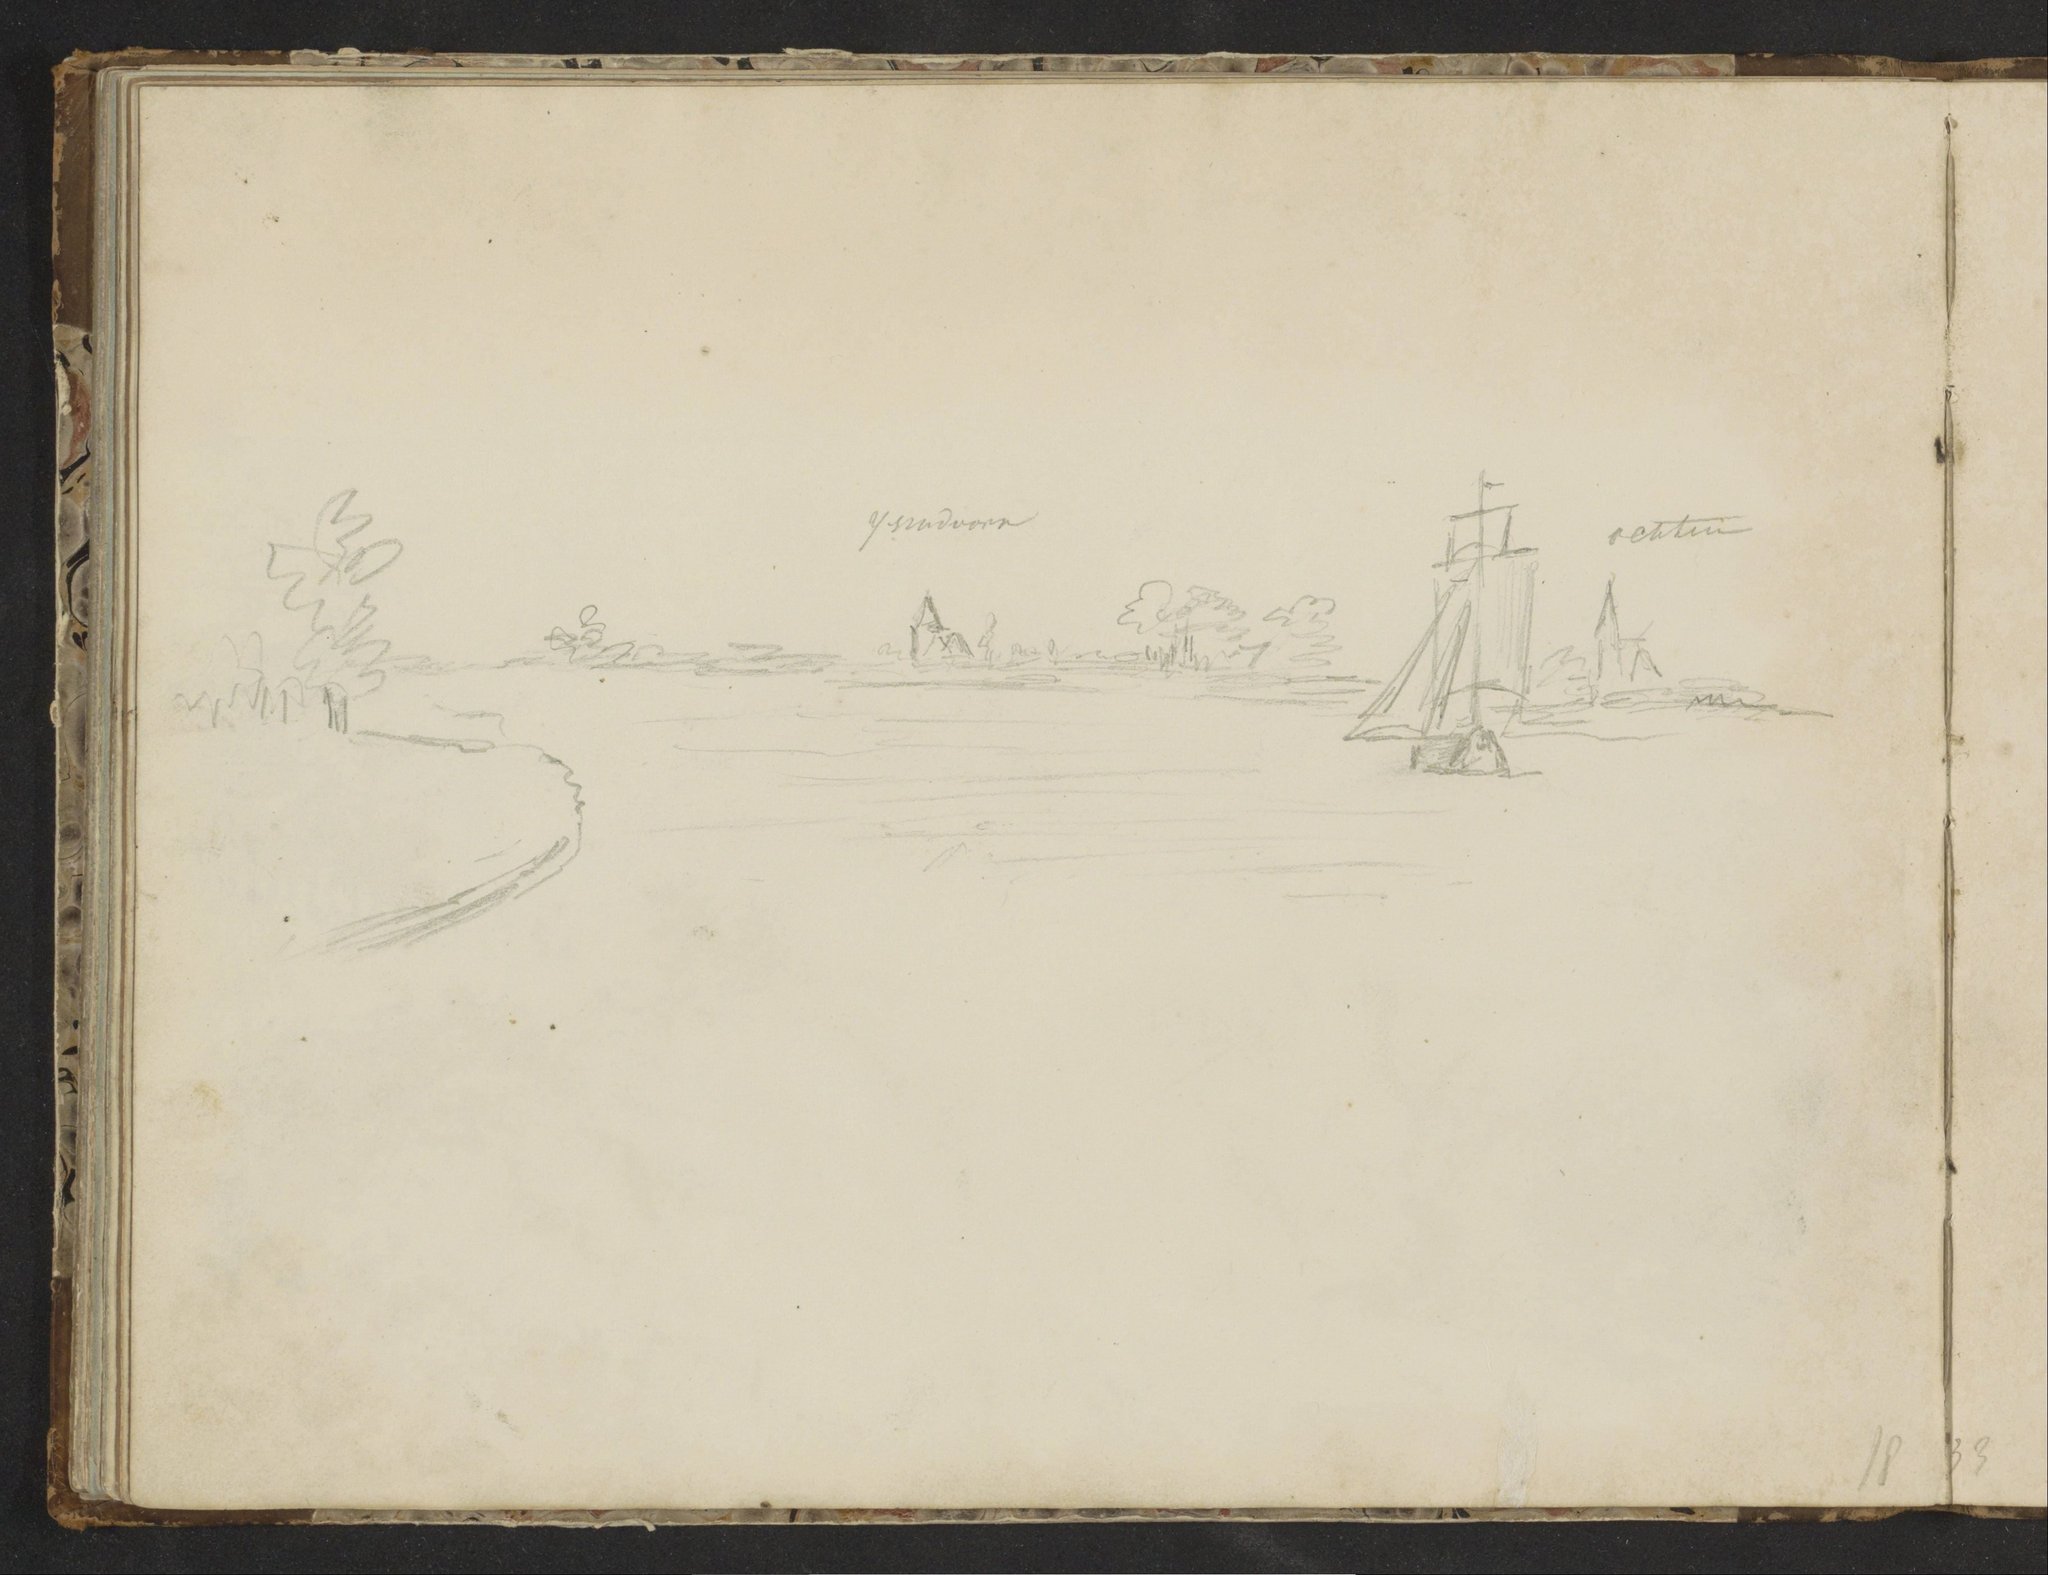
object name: sketchbook leaf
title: Gezicht op IJzendoorn en Ochten aan de Waal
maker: johannes tavenraat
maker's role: draughtsman, painter, print maker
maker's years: 1809-1881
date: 1833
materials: paper, pencil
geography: ochten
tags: sailing-ship, sailing-boat, landscapes with waters, waterscapes, seascapes (in the temperate zone)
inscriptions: date and inscription: ‘Yszendoorn/ ochten/ 18’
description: Blad 23 verso uit een schetsboek met 41 bladen.